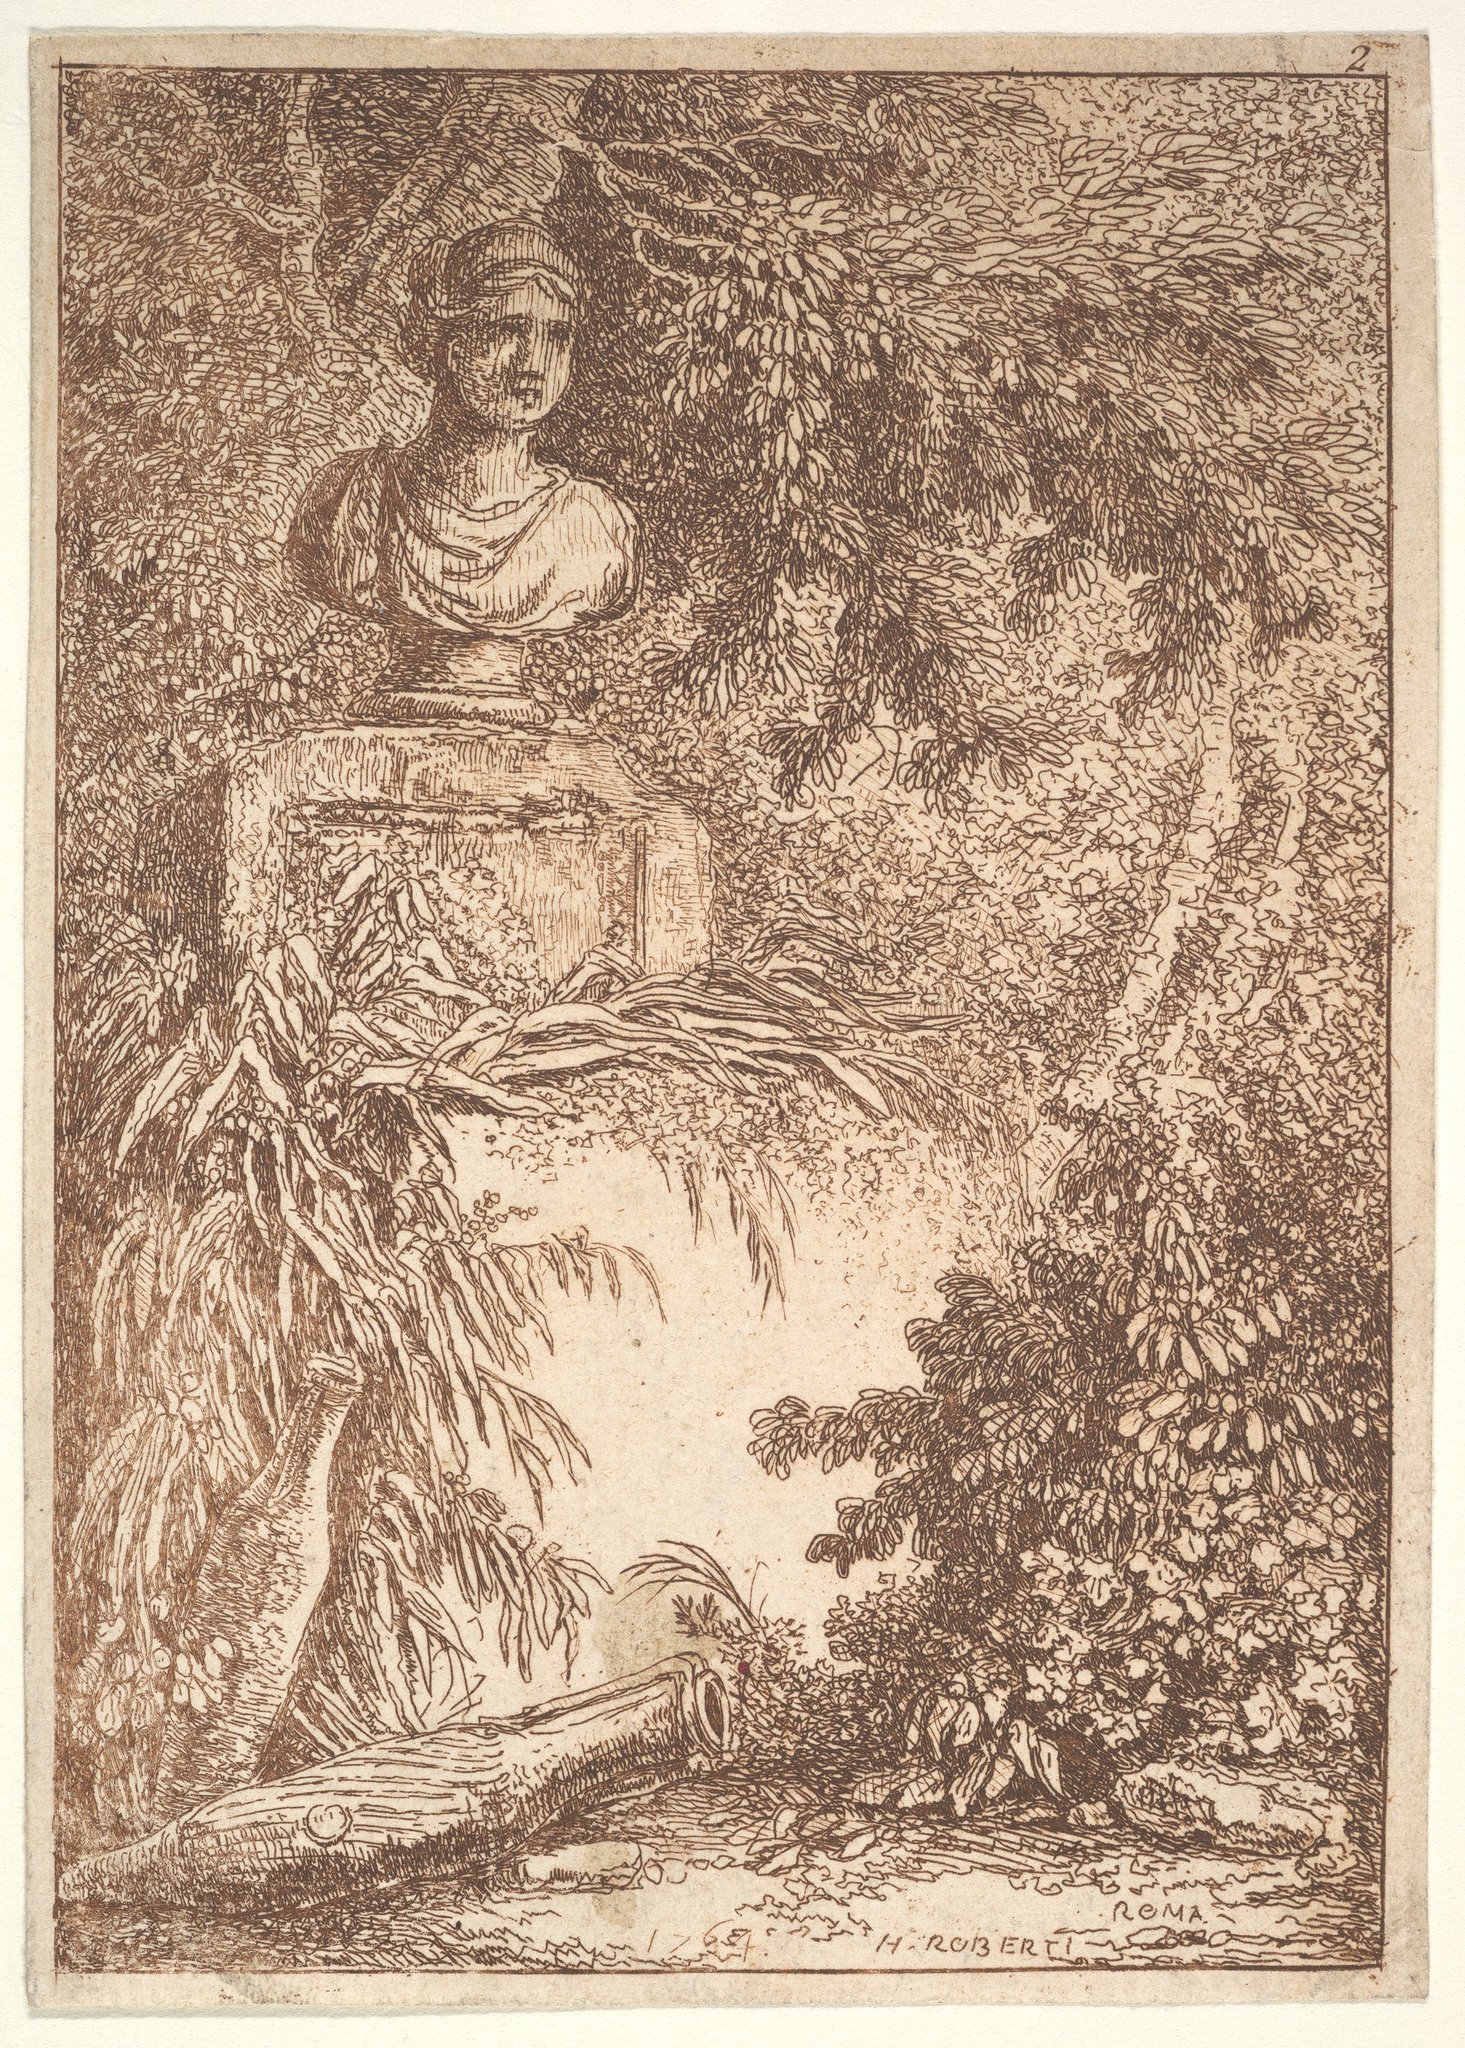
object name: print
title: Plate 2: The Bust: a bust of a female wearing a diadem at top left, two amphoras at bottom left, surrounded by trees and greenery, from "Les soirées de Rome"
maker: hubert robert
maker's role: artist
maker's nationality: french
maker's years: 1733-1808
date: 1764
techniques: etching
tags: diadems,women,trees